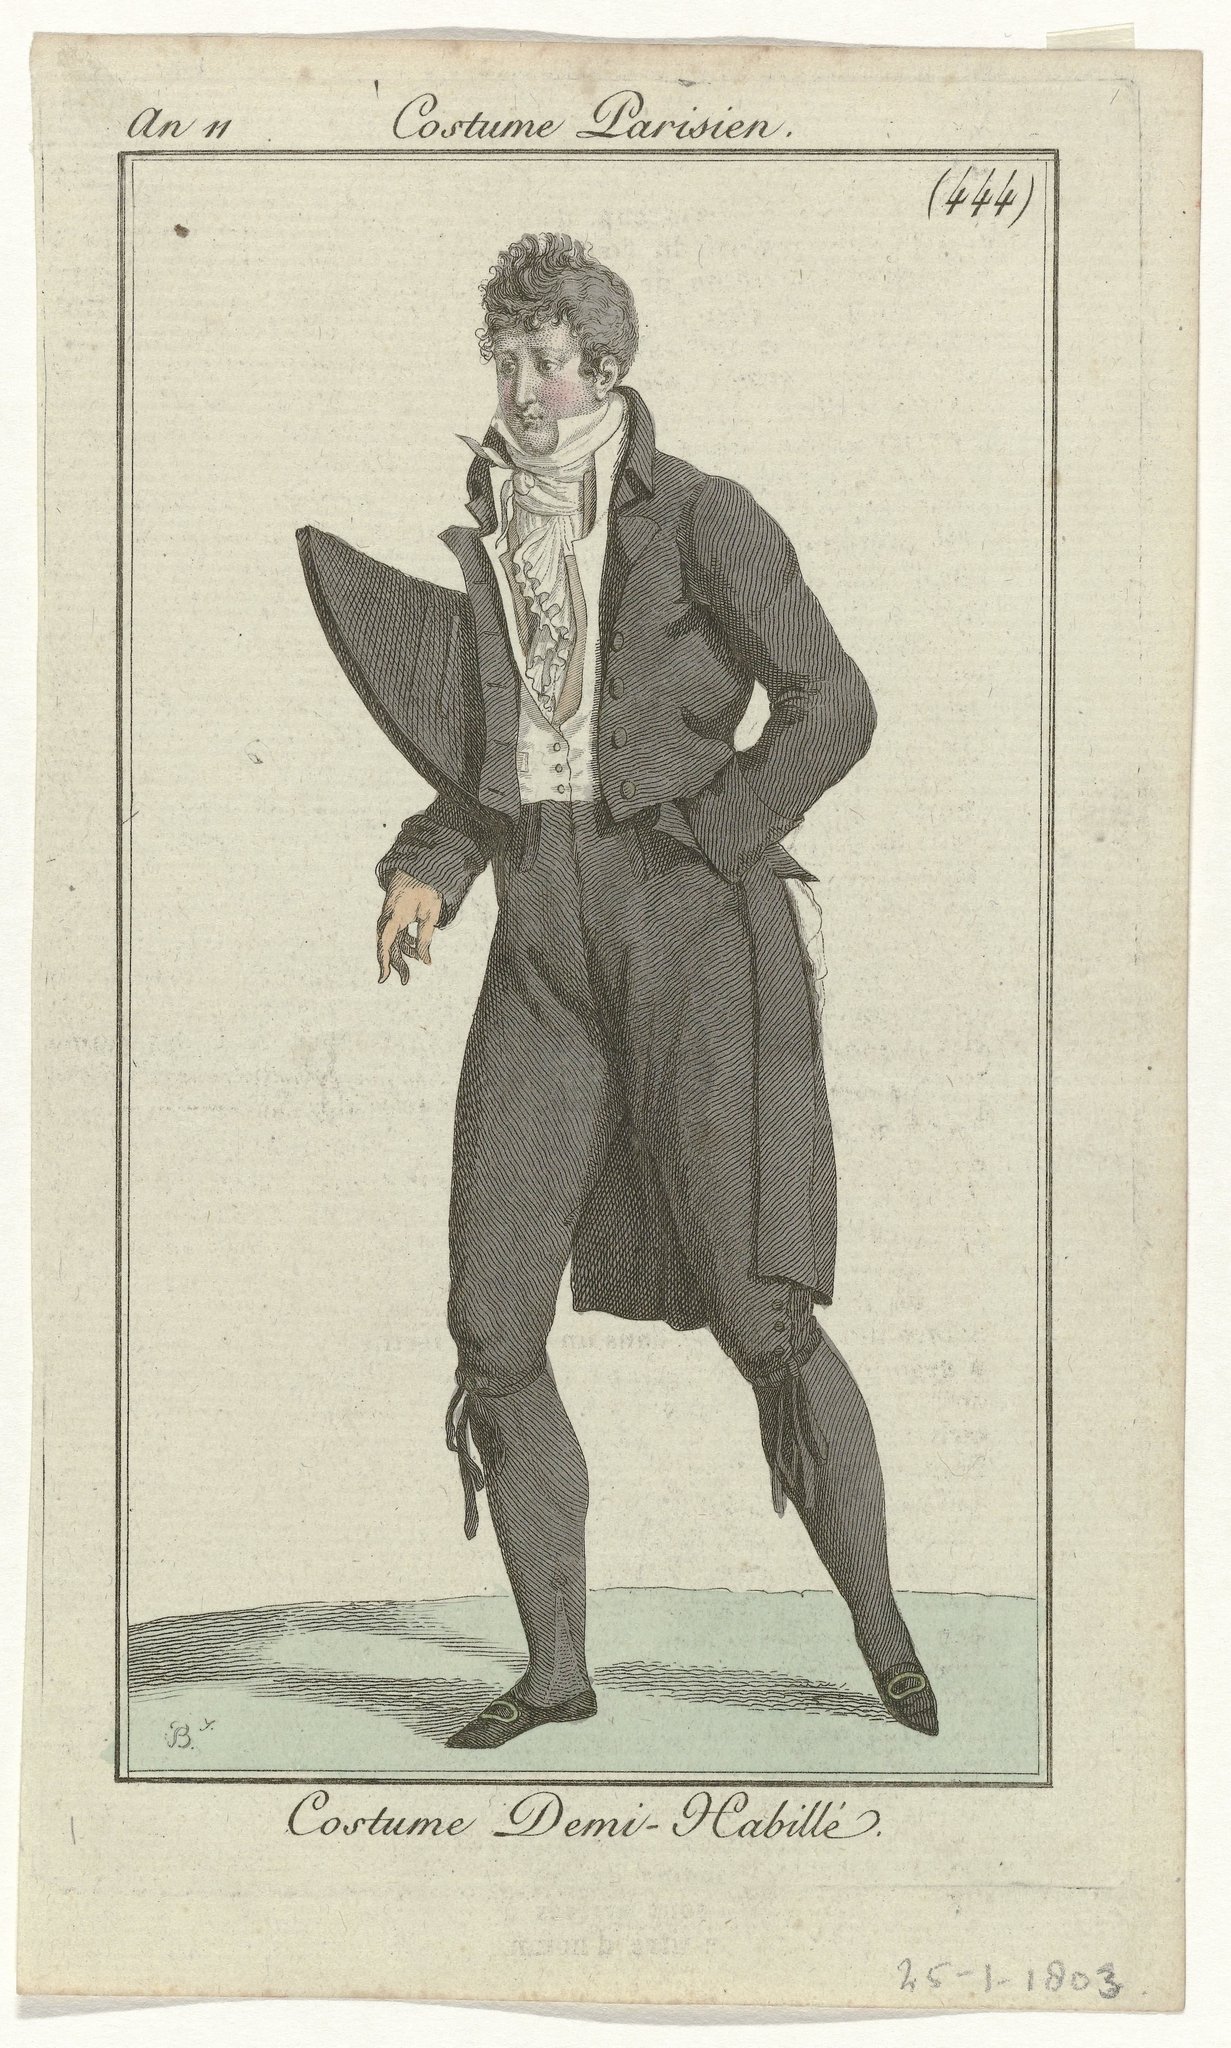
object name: fashion print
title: Journal des Dames et des Modes: Men’s Fashion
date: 1803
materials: paper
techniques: engraving, hand coloring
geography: paris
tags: clothing for the upper part of the body (vest) (+ men's clothes), neck-gear ~ clothing (cravat) (+ men's clothes), head-gear: hat (+ men's clothes), fashion plates, shoes, sandals (+ men's clothes), trousers, breeches, etc. (breeches) (+ men's clothes), gloves, mittens, etc. (+ men's clothes), stockings, socks (+ men's clothes)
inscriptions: caption: ‘Costume Demi-Habillé.’, title: ‘Costume Parisien.’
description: The Journal des Dames et des Modes occasionally provided coverage of men’s styles. These illustrations give a good picture of trends in mens’ clothing from 1797 to 1825. During the 18th century, gentlemen wore culotte (knee-breeches) 1. These fell out of fashion with the elimination of strict class distinctions during the French Revolution, to be replaced by a type of long trouser(s) known as pantalon à la Hussarde 2. These were worn with hussar boots. ‘Pantaloons’ 3 were trousers pulled tight with an elastic strap under the instep. Carrick 4 coats with a double collar were popular, and in the evenings men wore a special dress cloak 5.